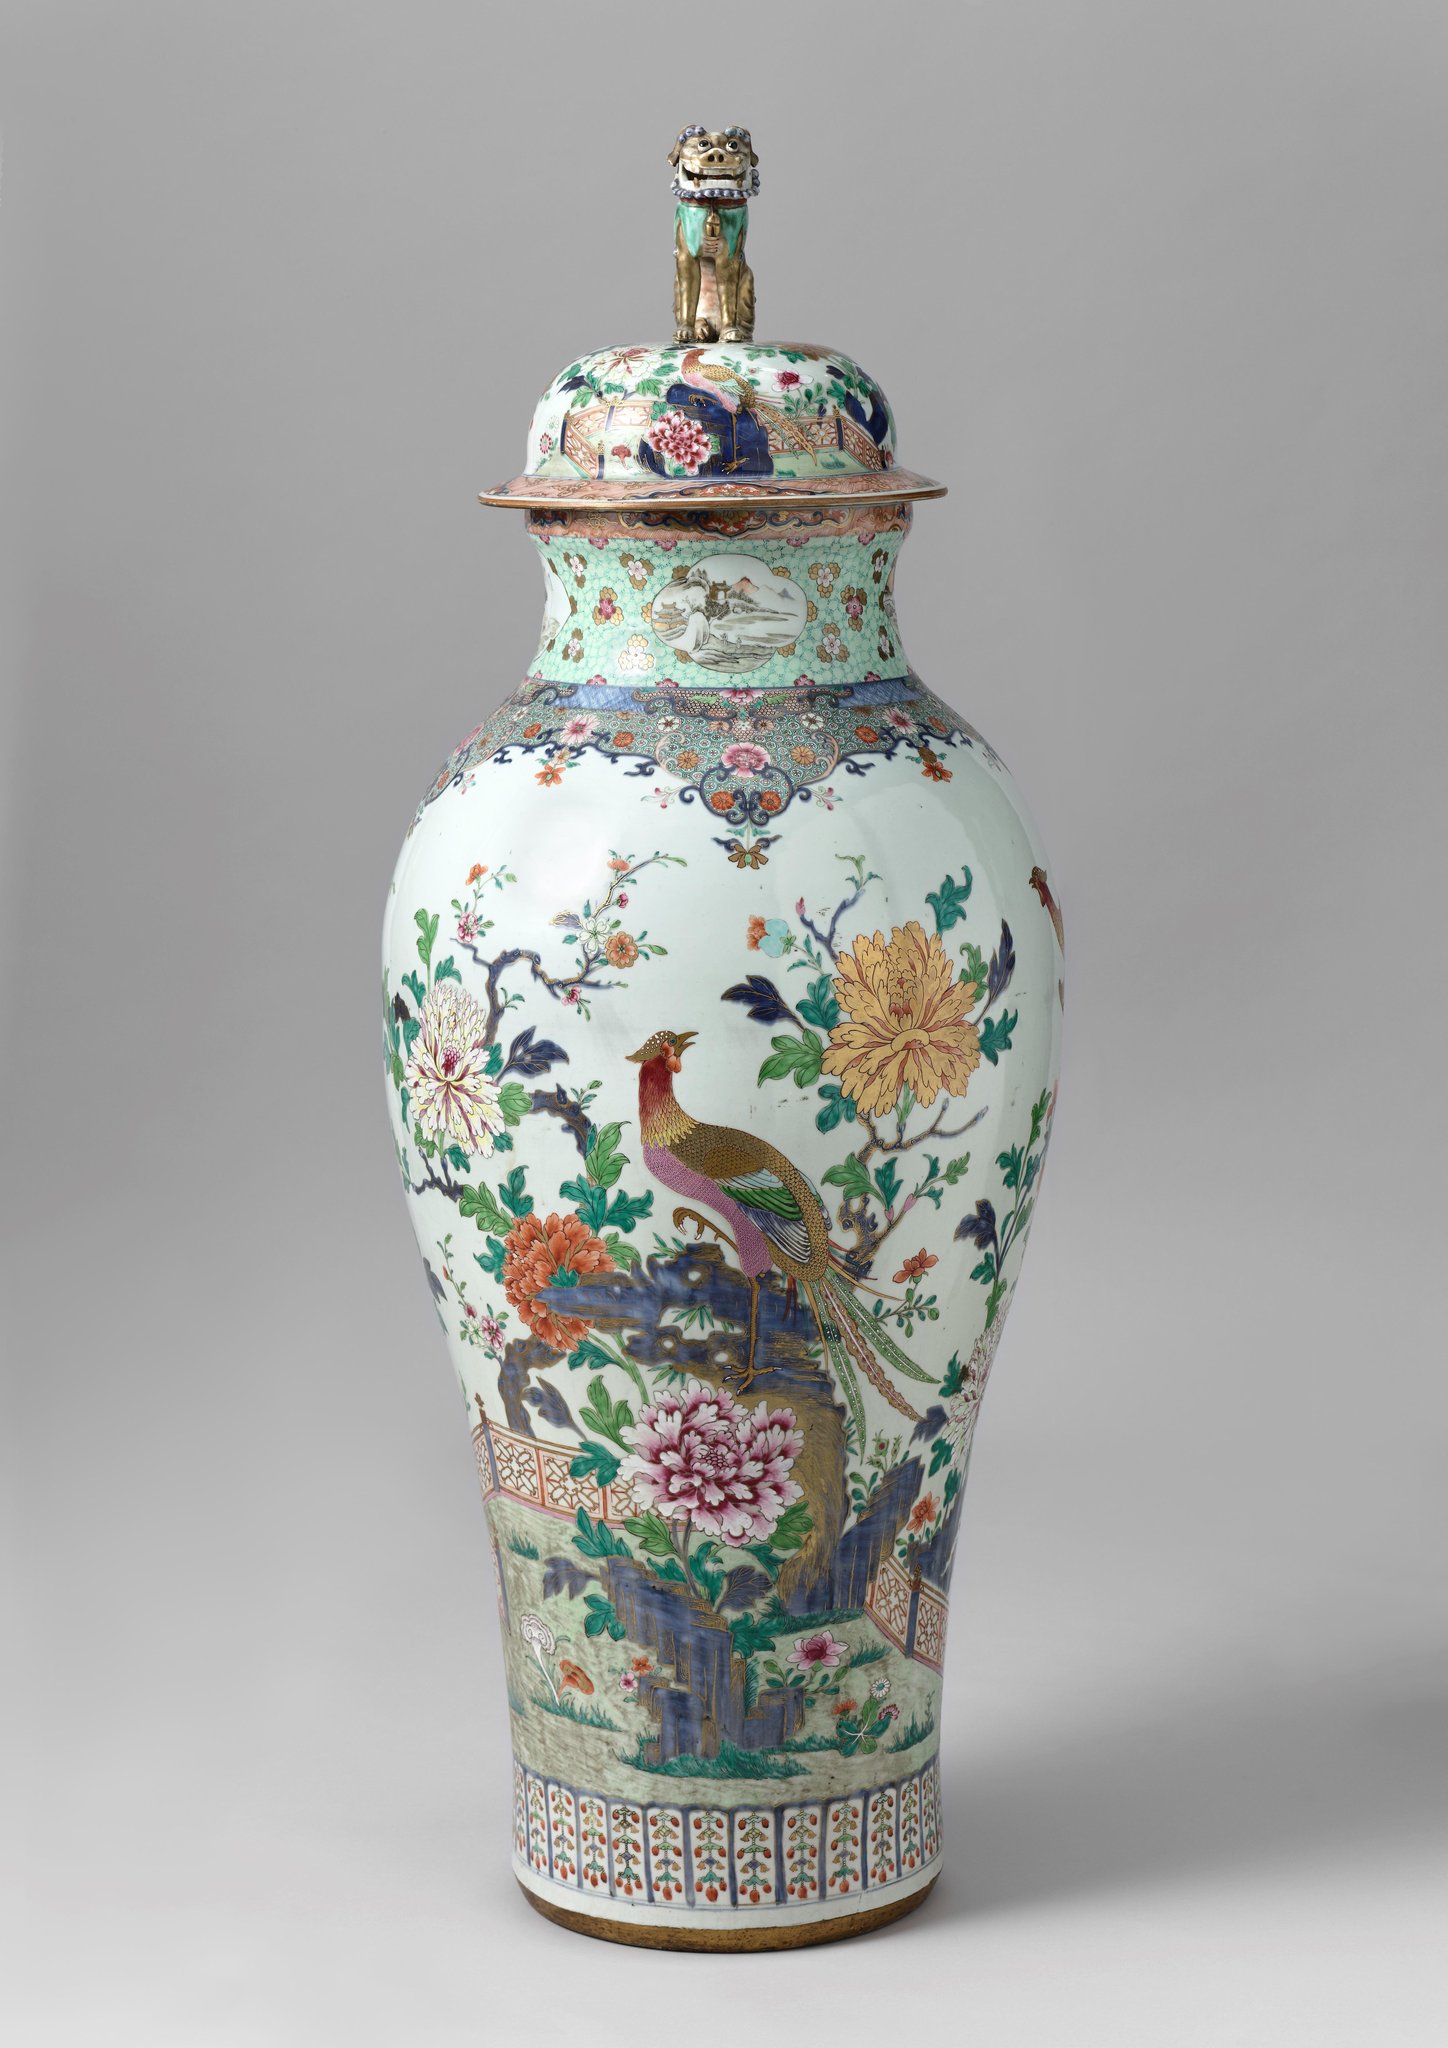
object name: pot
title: Two Lidded Vases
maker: Anonymous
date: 1750-1780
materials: cobalt, glaze, gold, paint, porcelain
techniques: firing, gilding, turning, vitrification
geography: china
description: Balustervormige pot van porselein, beschilderd in onderglazuur blauw en op het glazuur in blauw, rood, roze, groen, geel, zwart en goud. Op de wand een fazant op een rots bij bloeiende planten (pioen, prunus) en een hek. In de lucht vliegt een tweede fazant, vlinders en vogels. Op de grond andere bloemen (aster, lotus, prachtanjer), paddenstoelen (lingzhi) en een vijver met eenden. Op de schouder een decoratieve band van kleine bloemrozetten met daarop krulwerk en losse bloemen. Boven de voet een band met gestileerde bladmotieven gevuld met slingers met gelukssymbolen (muzieksteen, munt, ruit). Op de nek een band met 'crackled ice' en prunusbloesems onderbroken door gelobde cartouches met een landschap in ence de Chine. De buitenrand in Imari-kleuren met een band met wolken op arceerwerk onderbroken door cartouches met lotusranken. Famille rose.